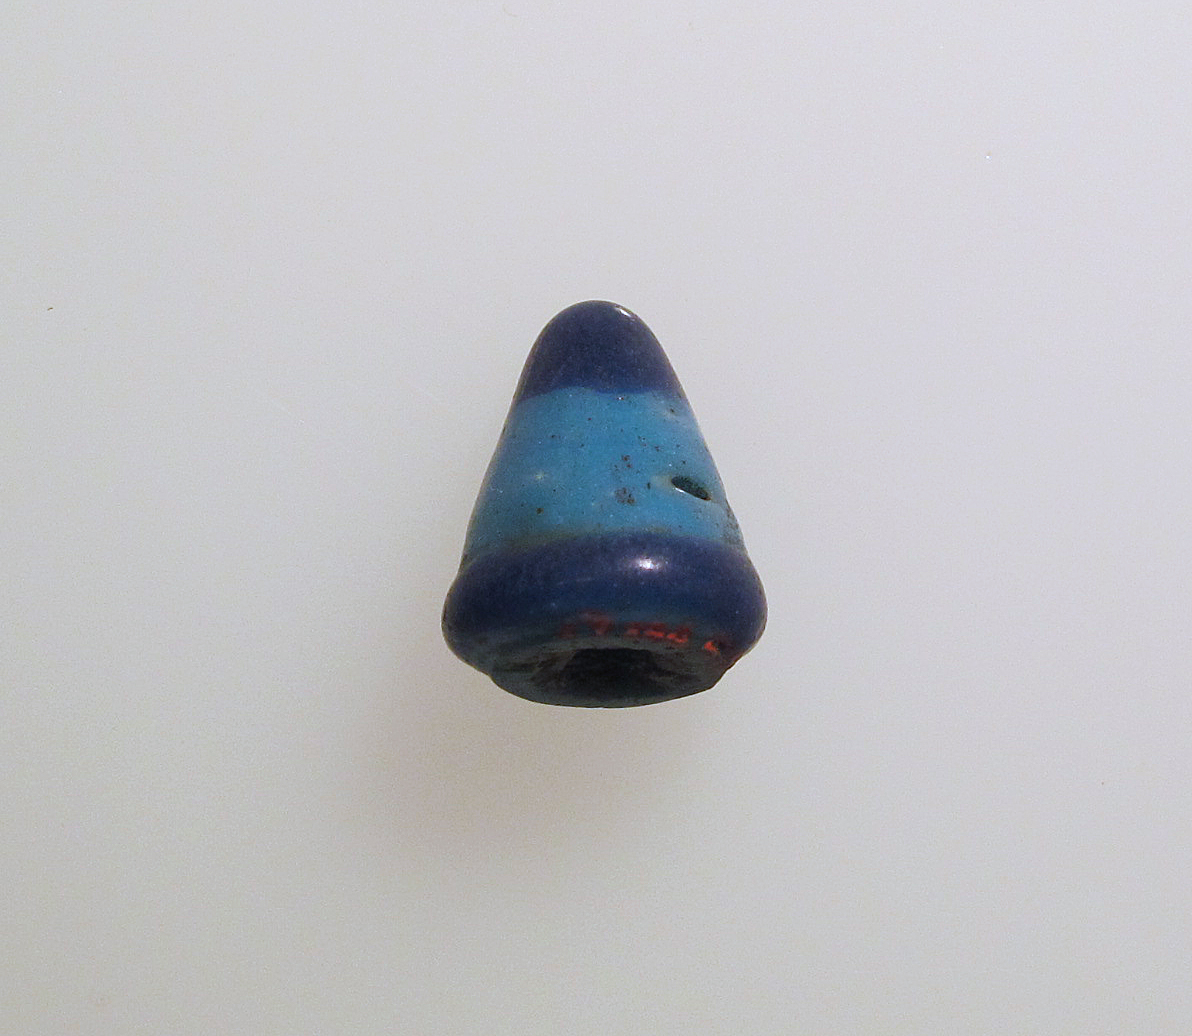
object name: ornament cone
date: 7000 BCE-330 CE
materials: glass